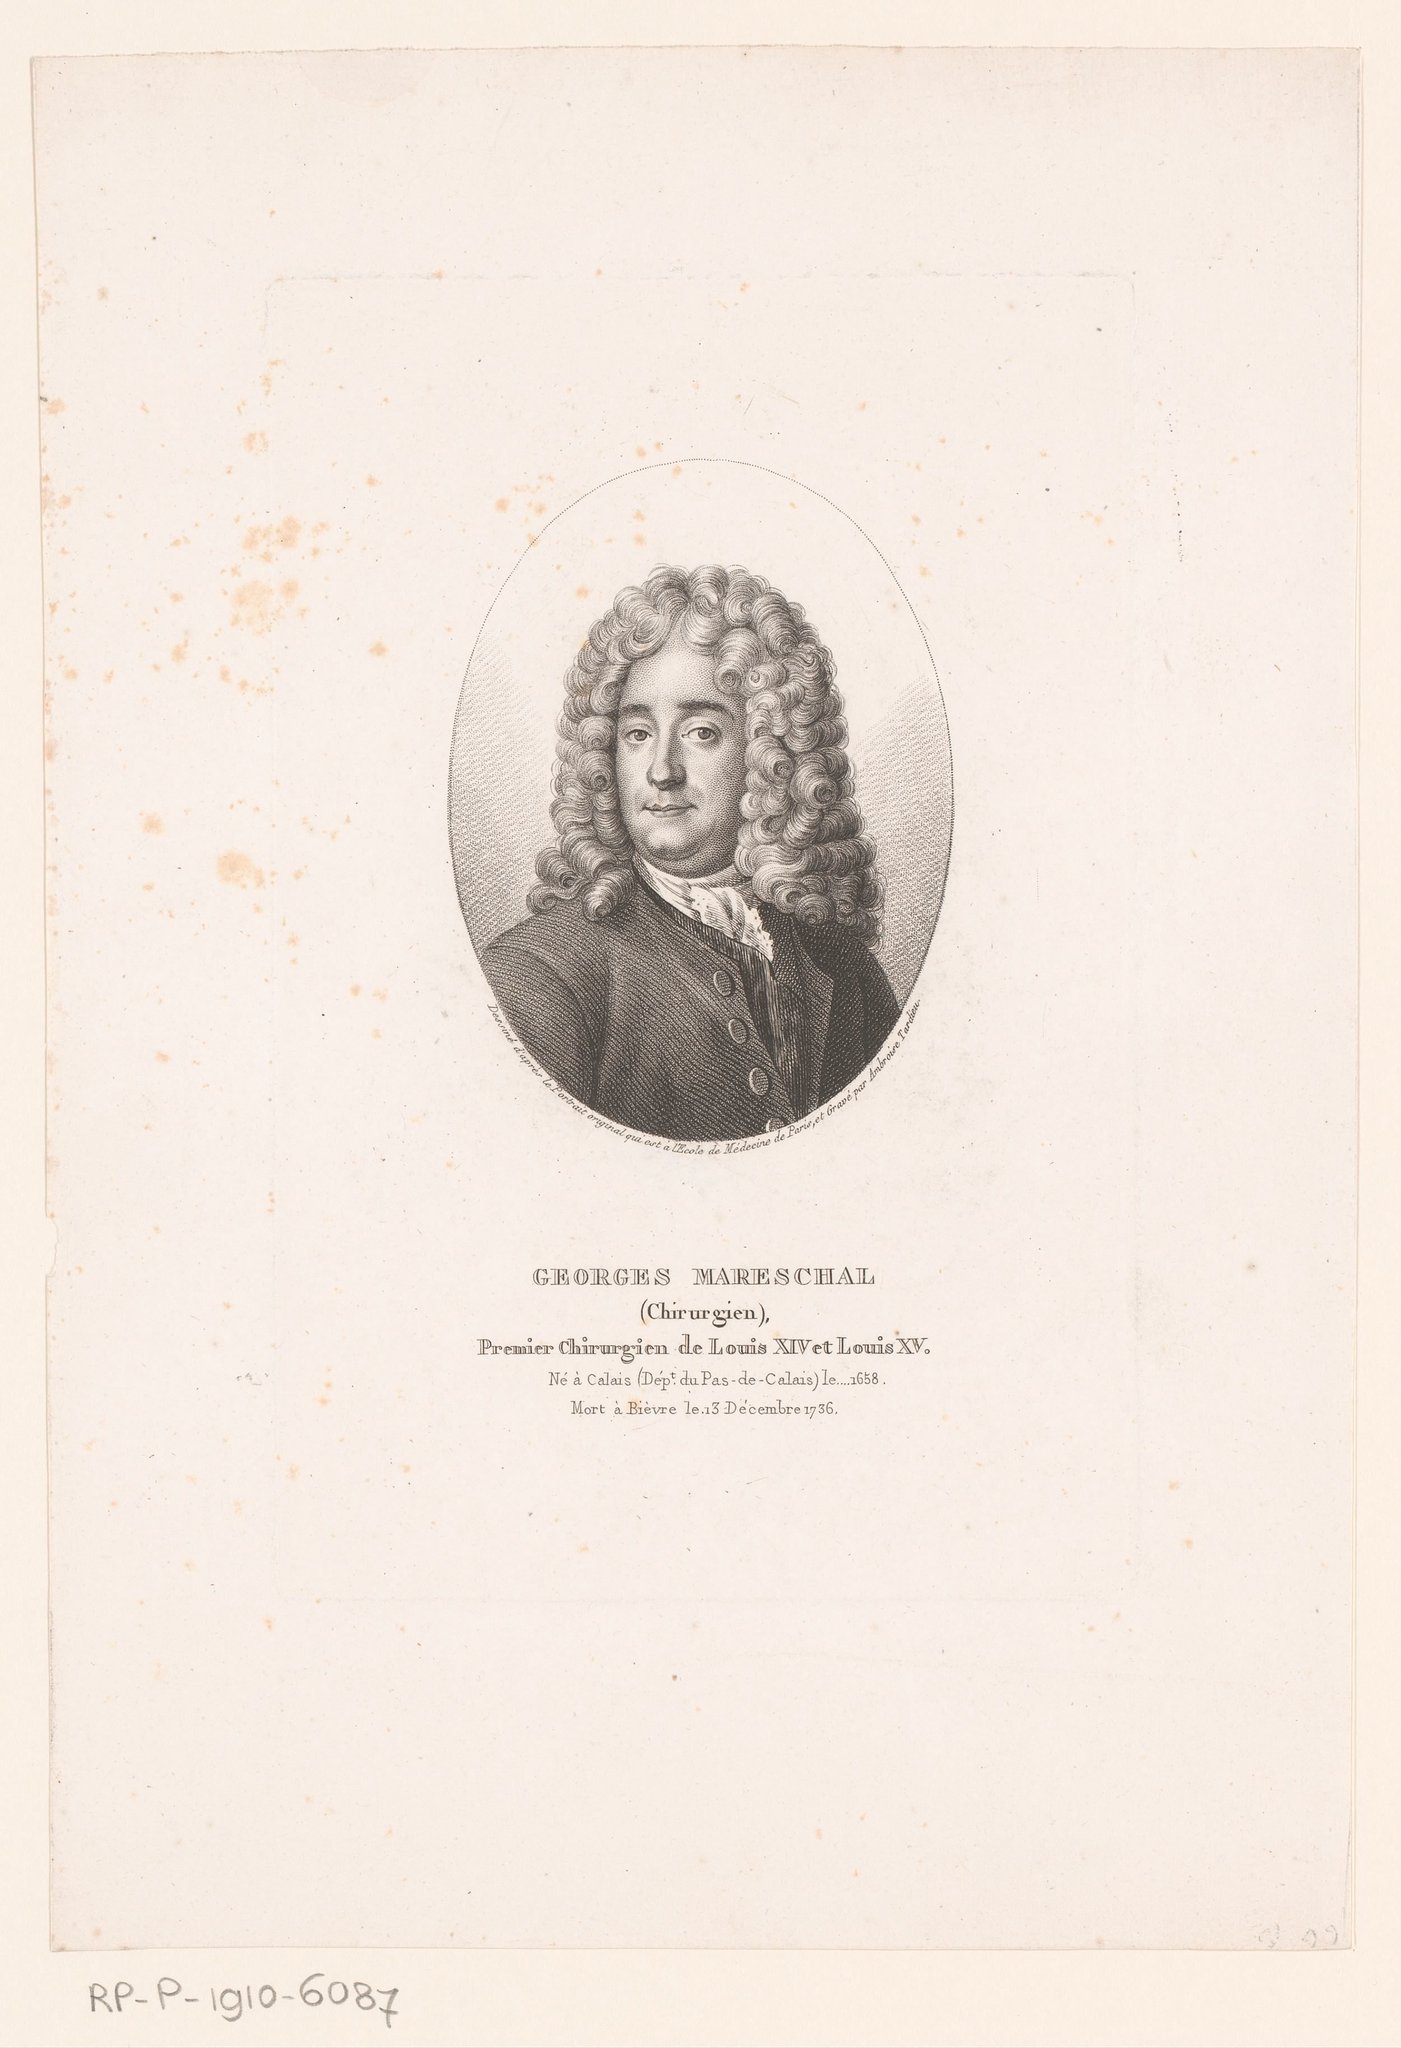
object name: print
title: Collection de tous les personnages célèbres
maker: ambroise tardieu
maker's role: print maker, printer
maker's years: 1788-1841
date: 1820-1828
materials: paper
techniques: engraving, roulette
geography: paris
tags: historical persons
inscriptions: collector's mark: Lugt 2228